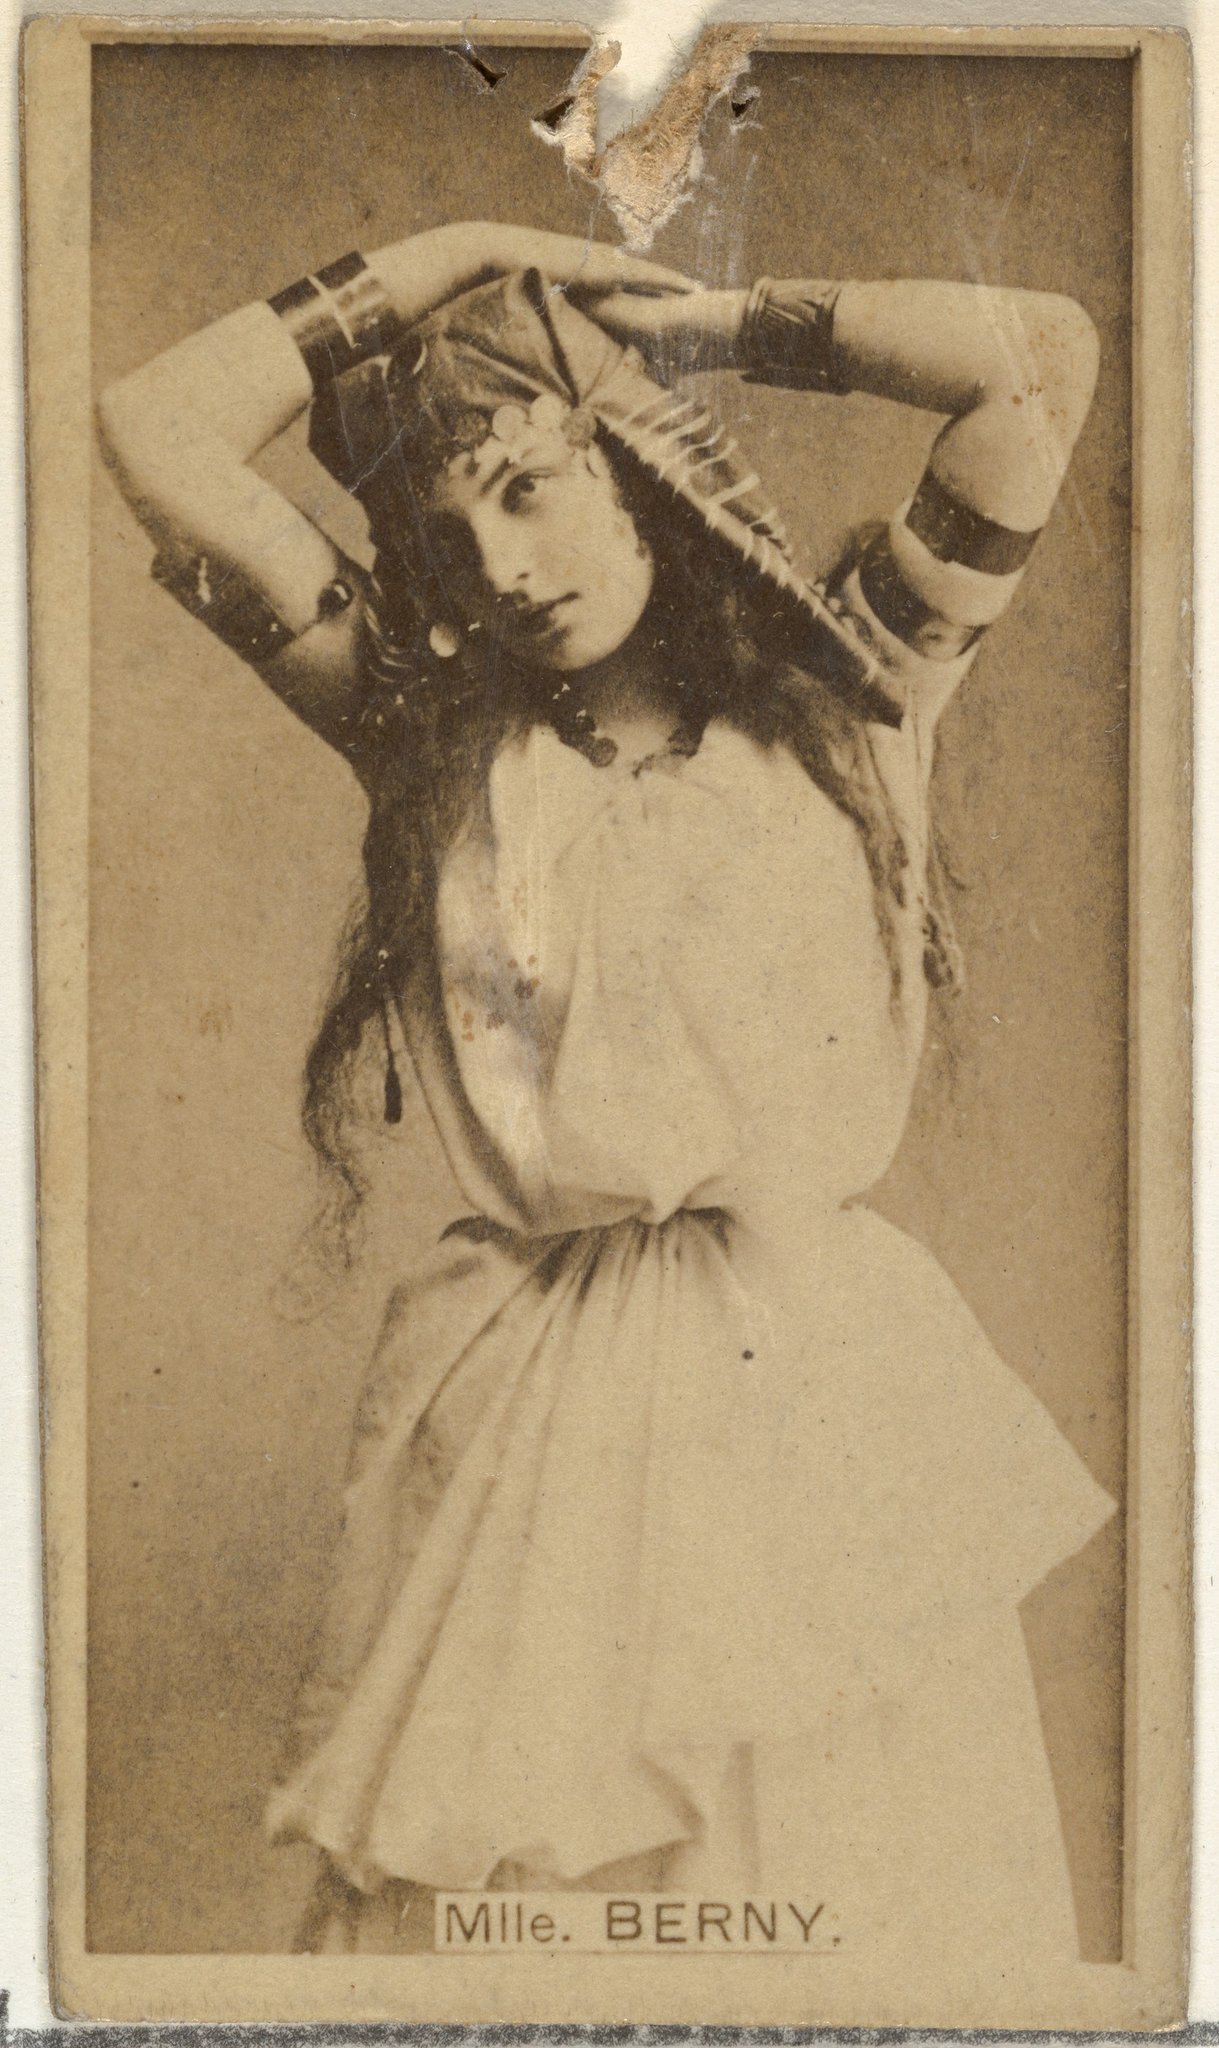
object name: photograph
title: Mlle. Berny, from the Actors and Actresses series (N145-8) issued by Duke Sons & Co. to promote Duke Cigarettes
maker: w. duke, sons & co.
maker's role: publisher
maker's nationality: american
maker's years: 1870-1920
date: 1891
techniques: albumen silver print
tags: portraits,women,actresses